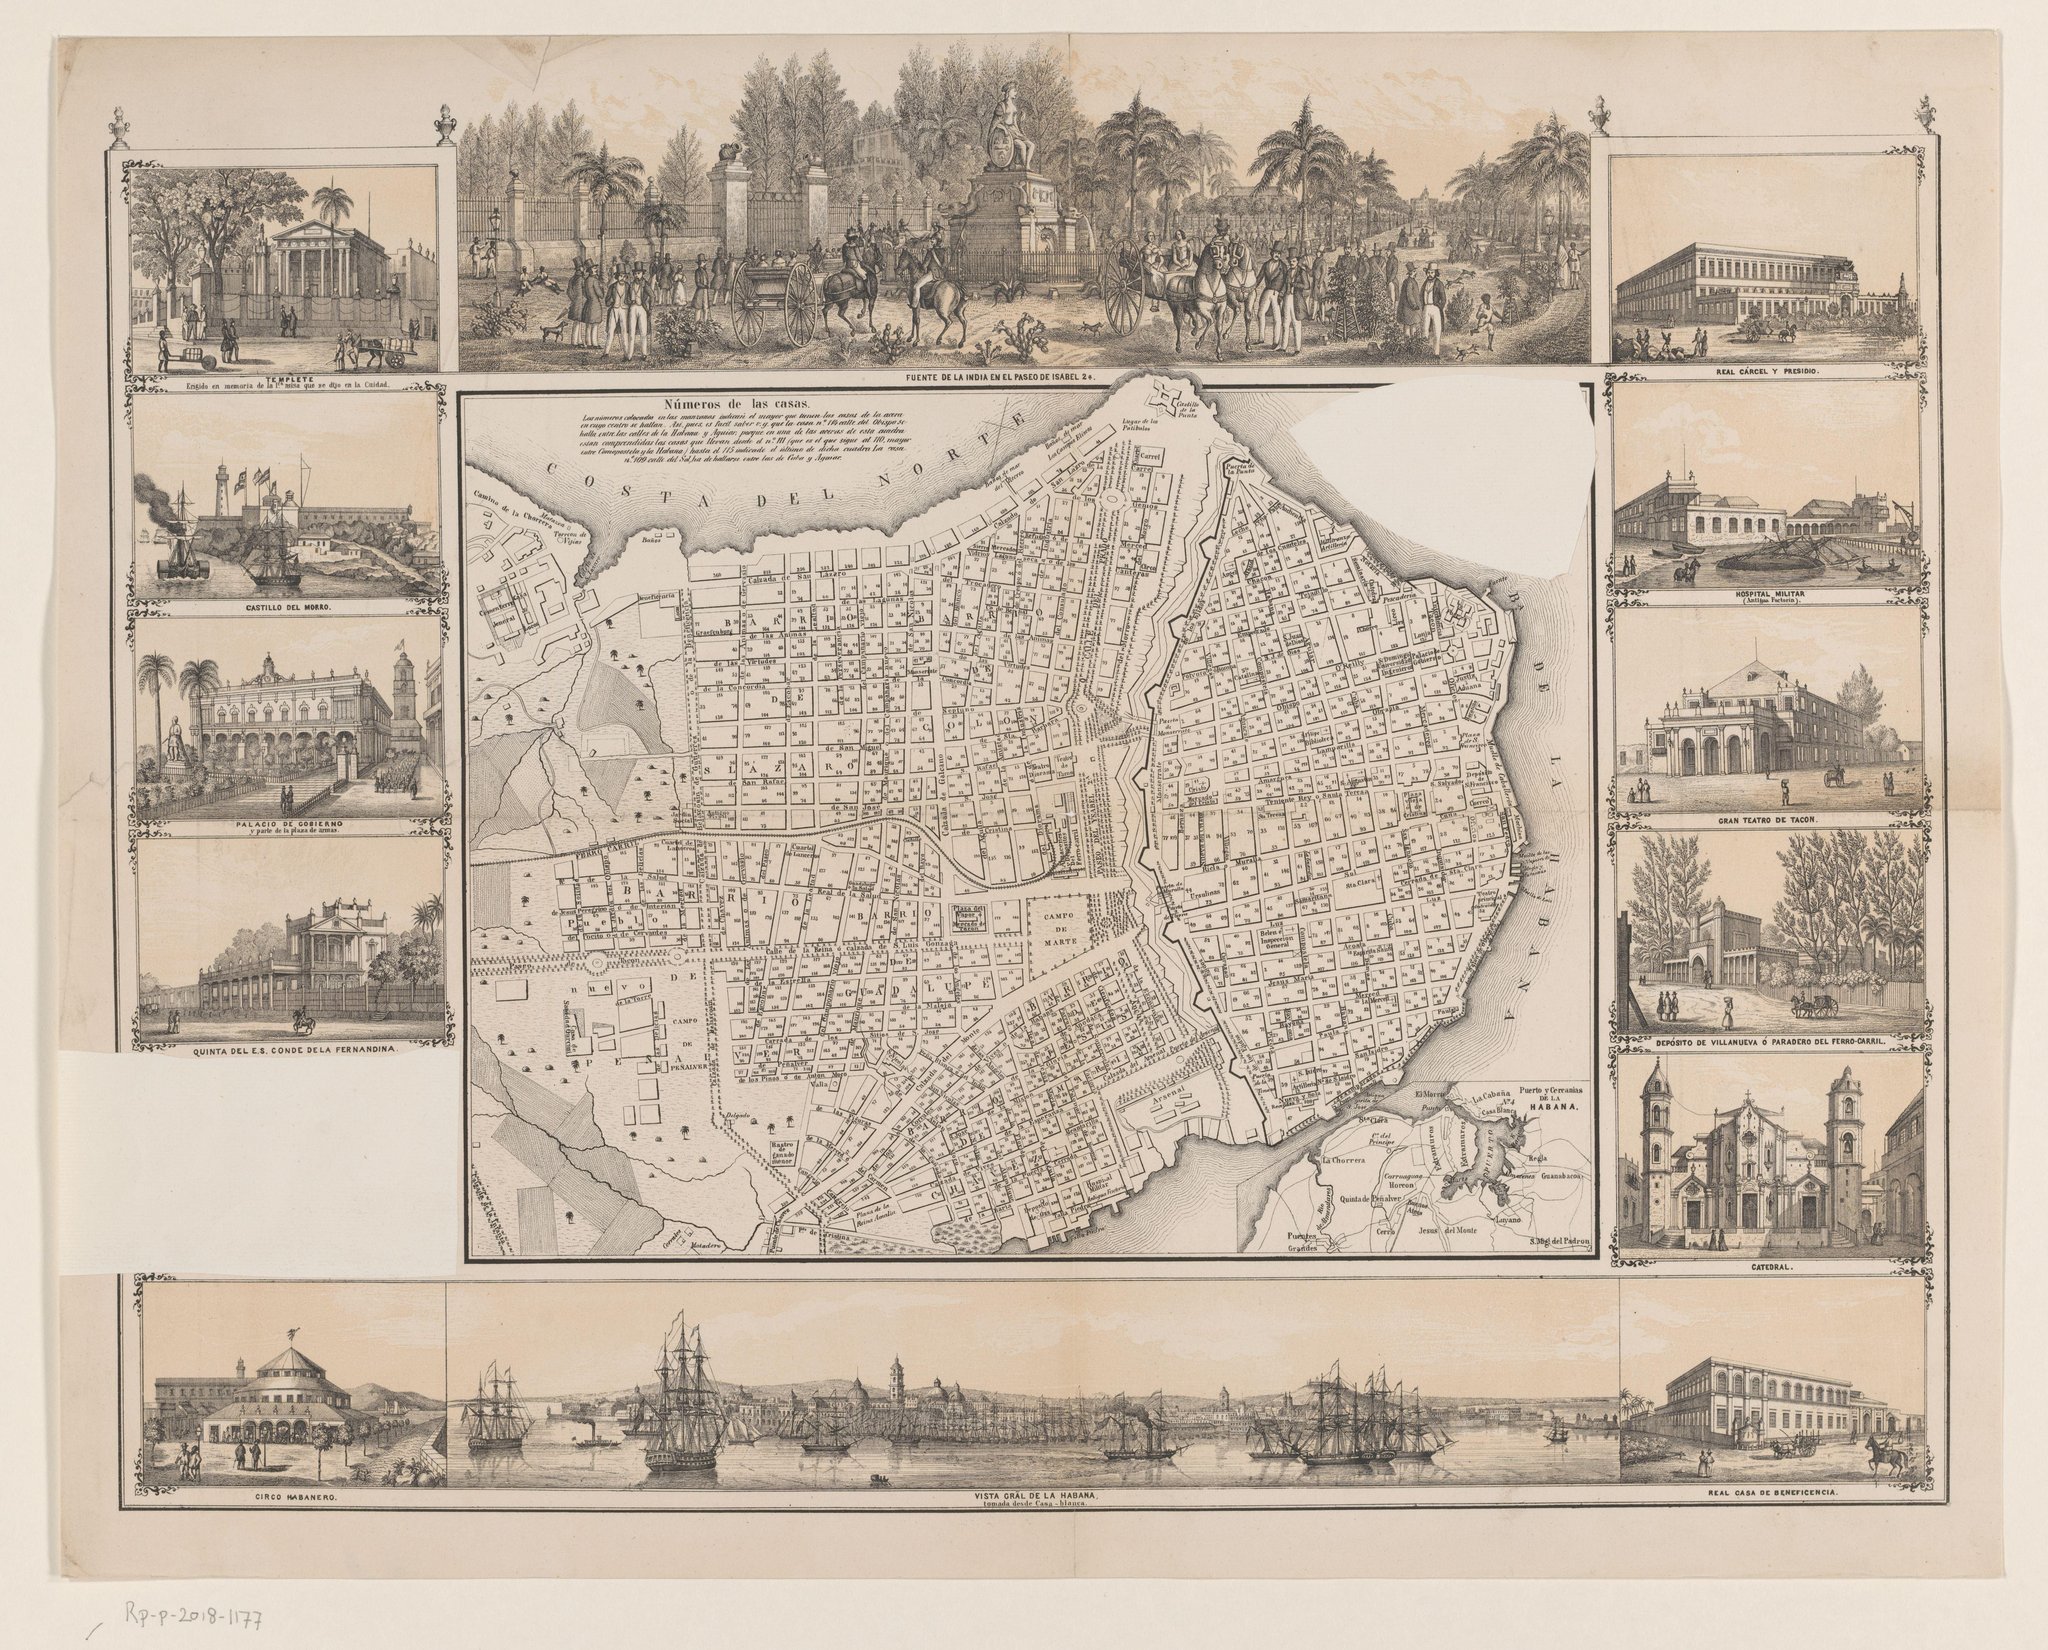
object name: print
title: Plattegrond van Havana met gezichten op de stad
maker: Anonymous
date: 1853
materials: paper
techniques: tone lithography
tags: maps of cities, prospect of city, town panorama, silhouette of city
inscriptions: collector's mark: Lugt 2228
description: In de prent zijn twee stukken weggeknipt. Rechtsboven de titel en linksonder een gezicht op een opslagplaats voor gas.